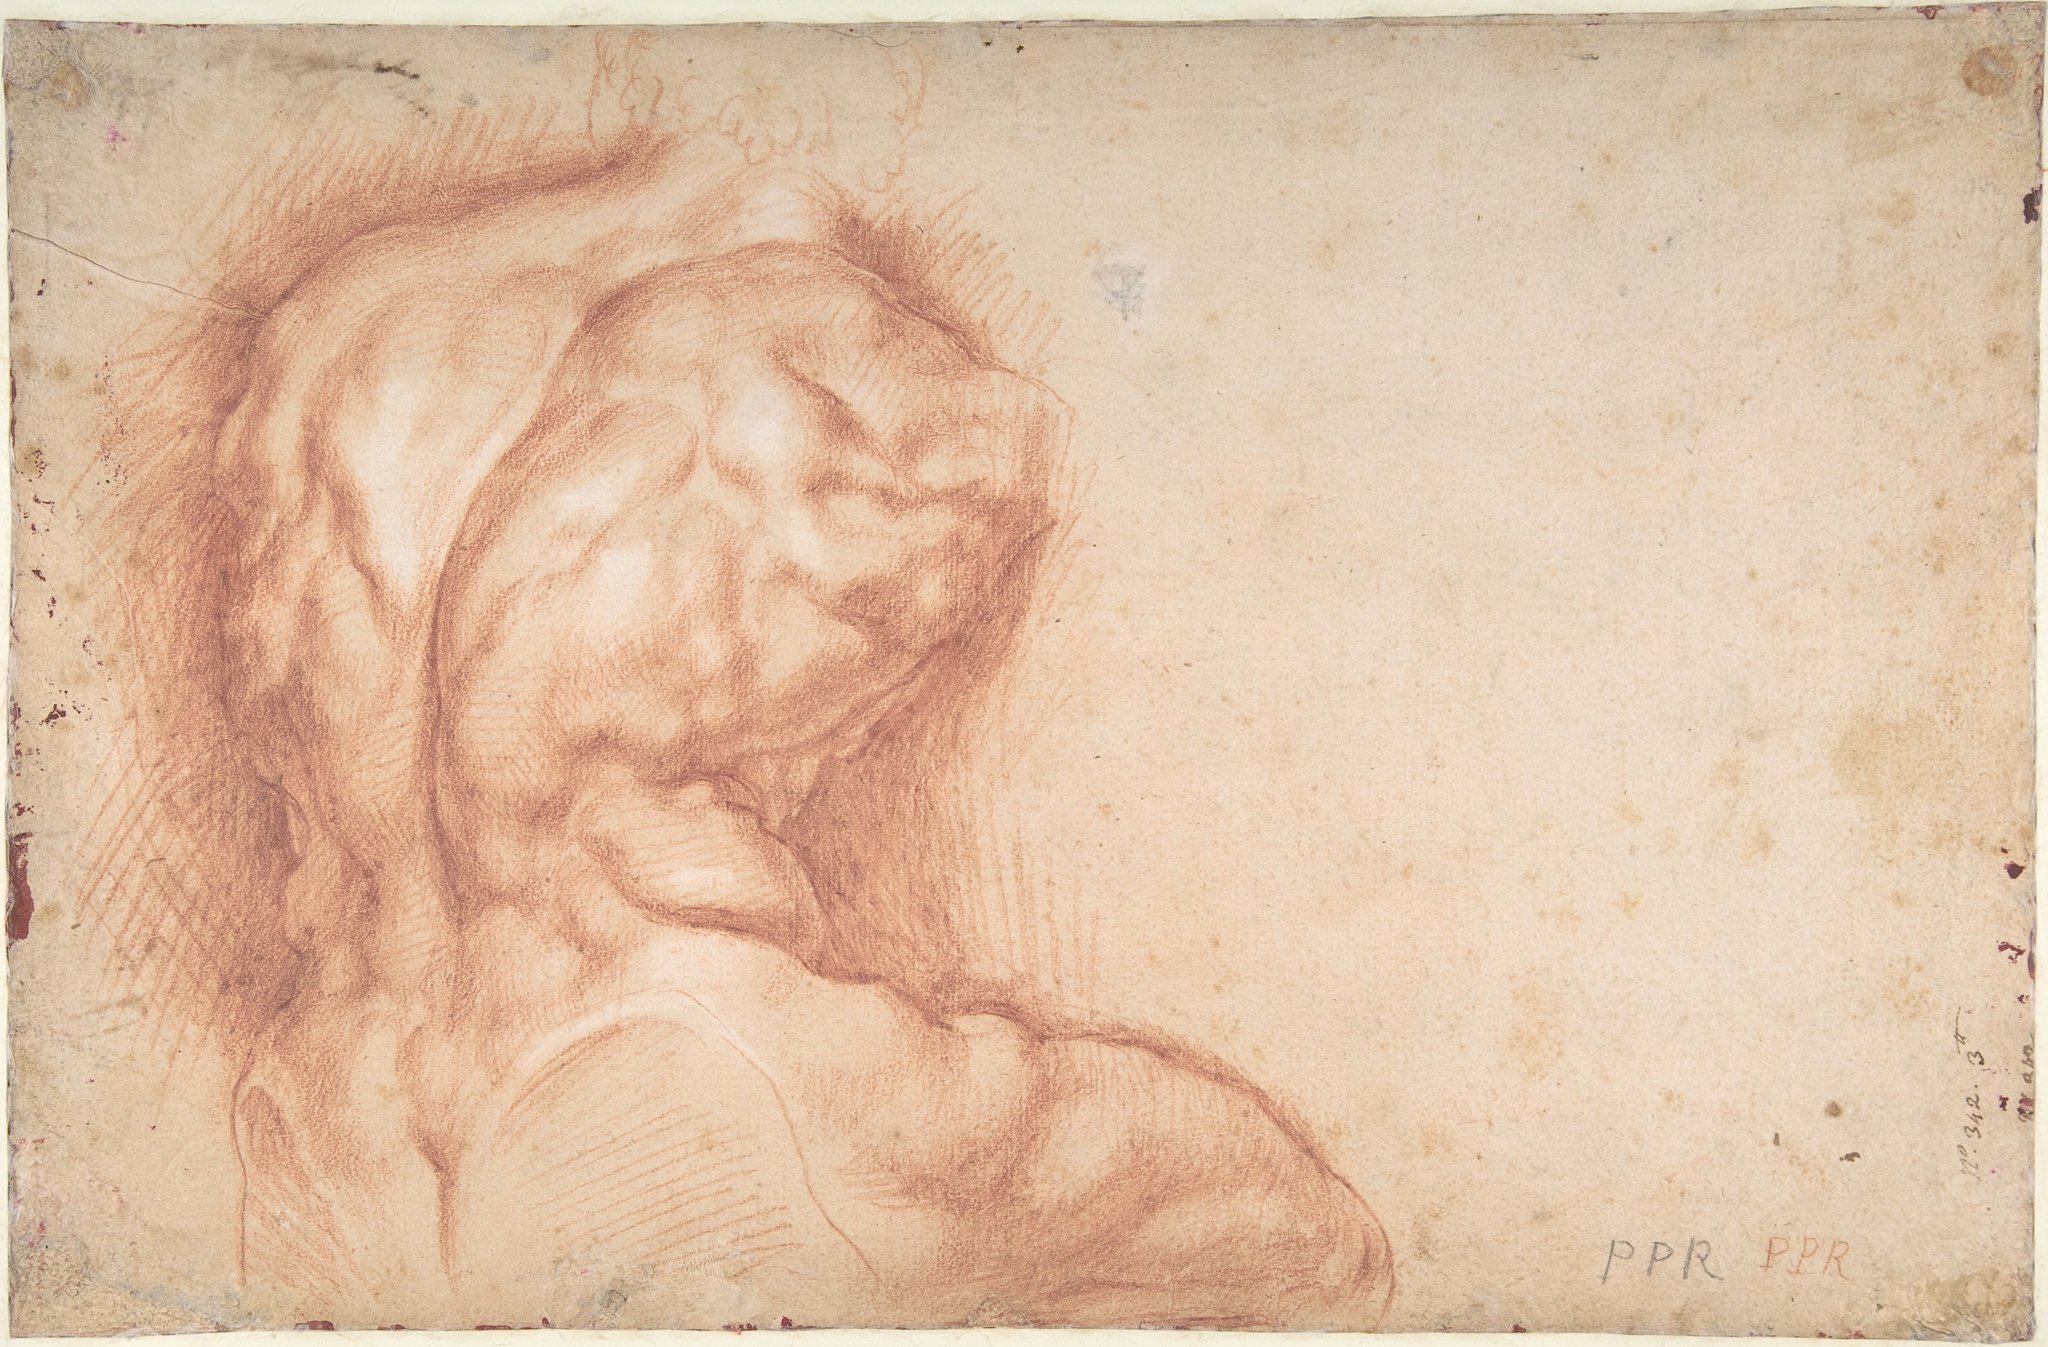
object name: drawing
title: The Virgin Adored by Saints (recto); Study of the Torso Belvedere (verso)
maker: peter paul rubens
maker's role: artist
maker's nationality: flemish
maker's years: 1577-1640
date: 1597-1640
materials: chalk, ink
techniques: pen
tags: male nudes,virgin mary,saints